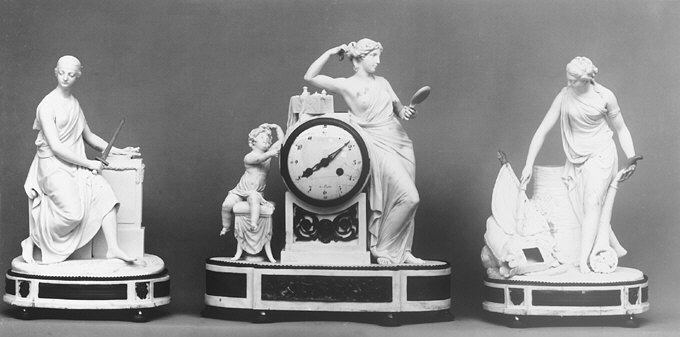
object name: figure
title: Peace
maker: dihl et guérhard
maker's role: factory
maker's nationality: french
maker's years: 1781-1824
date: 1781-1789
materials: biscuit, gilt bronze, paste, porcelain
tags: women